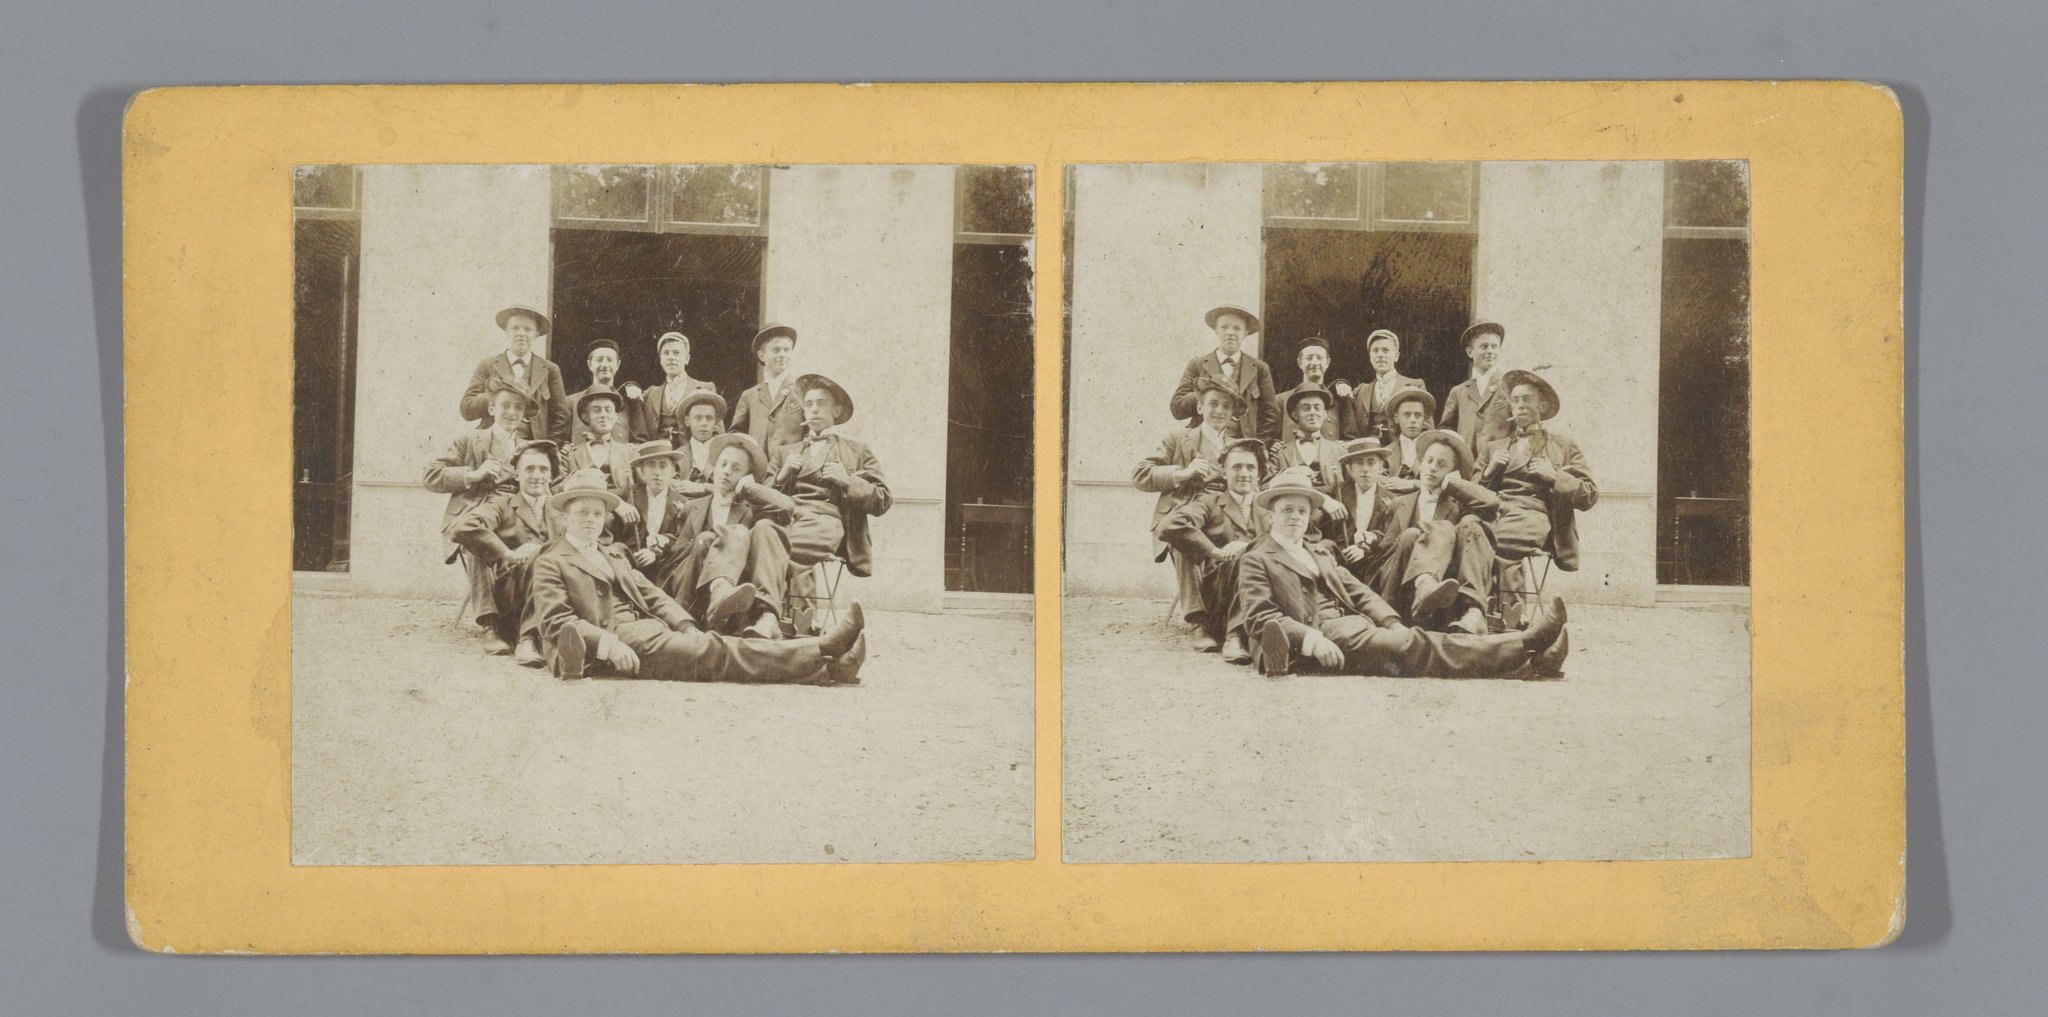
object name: stereograph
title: Portret van een groep onbekende jongens voor een gebouw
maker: Anonymous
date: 1899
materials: cardboard, photographic support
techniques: collodion silver print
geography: europe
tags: open door, europe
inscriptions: inscription: ‘24 Juli 1899’